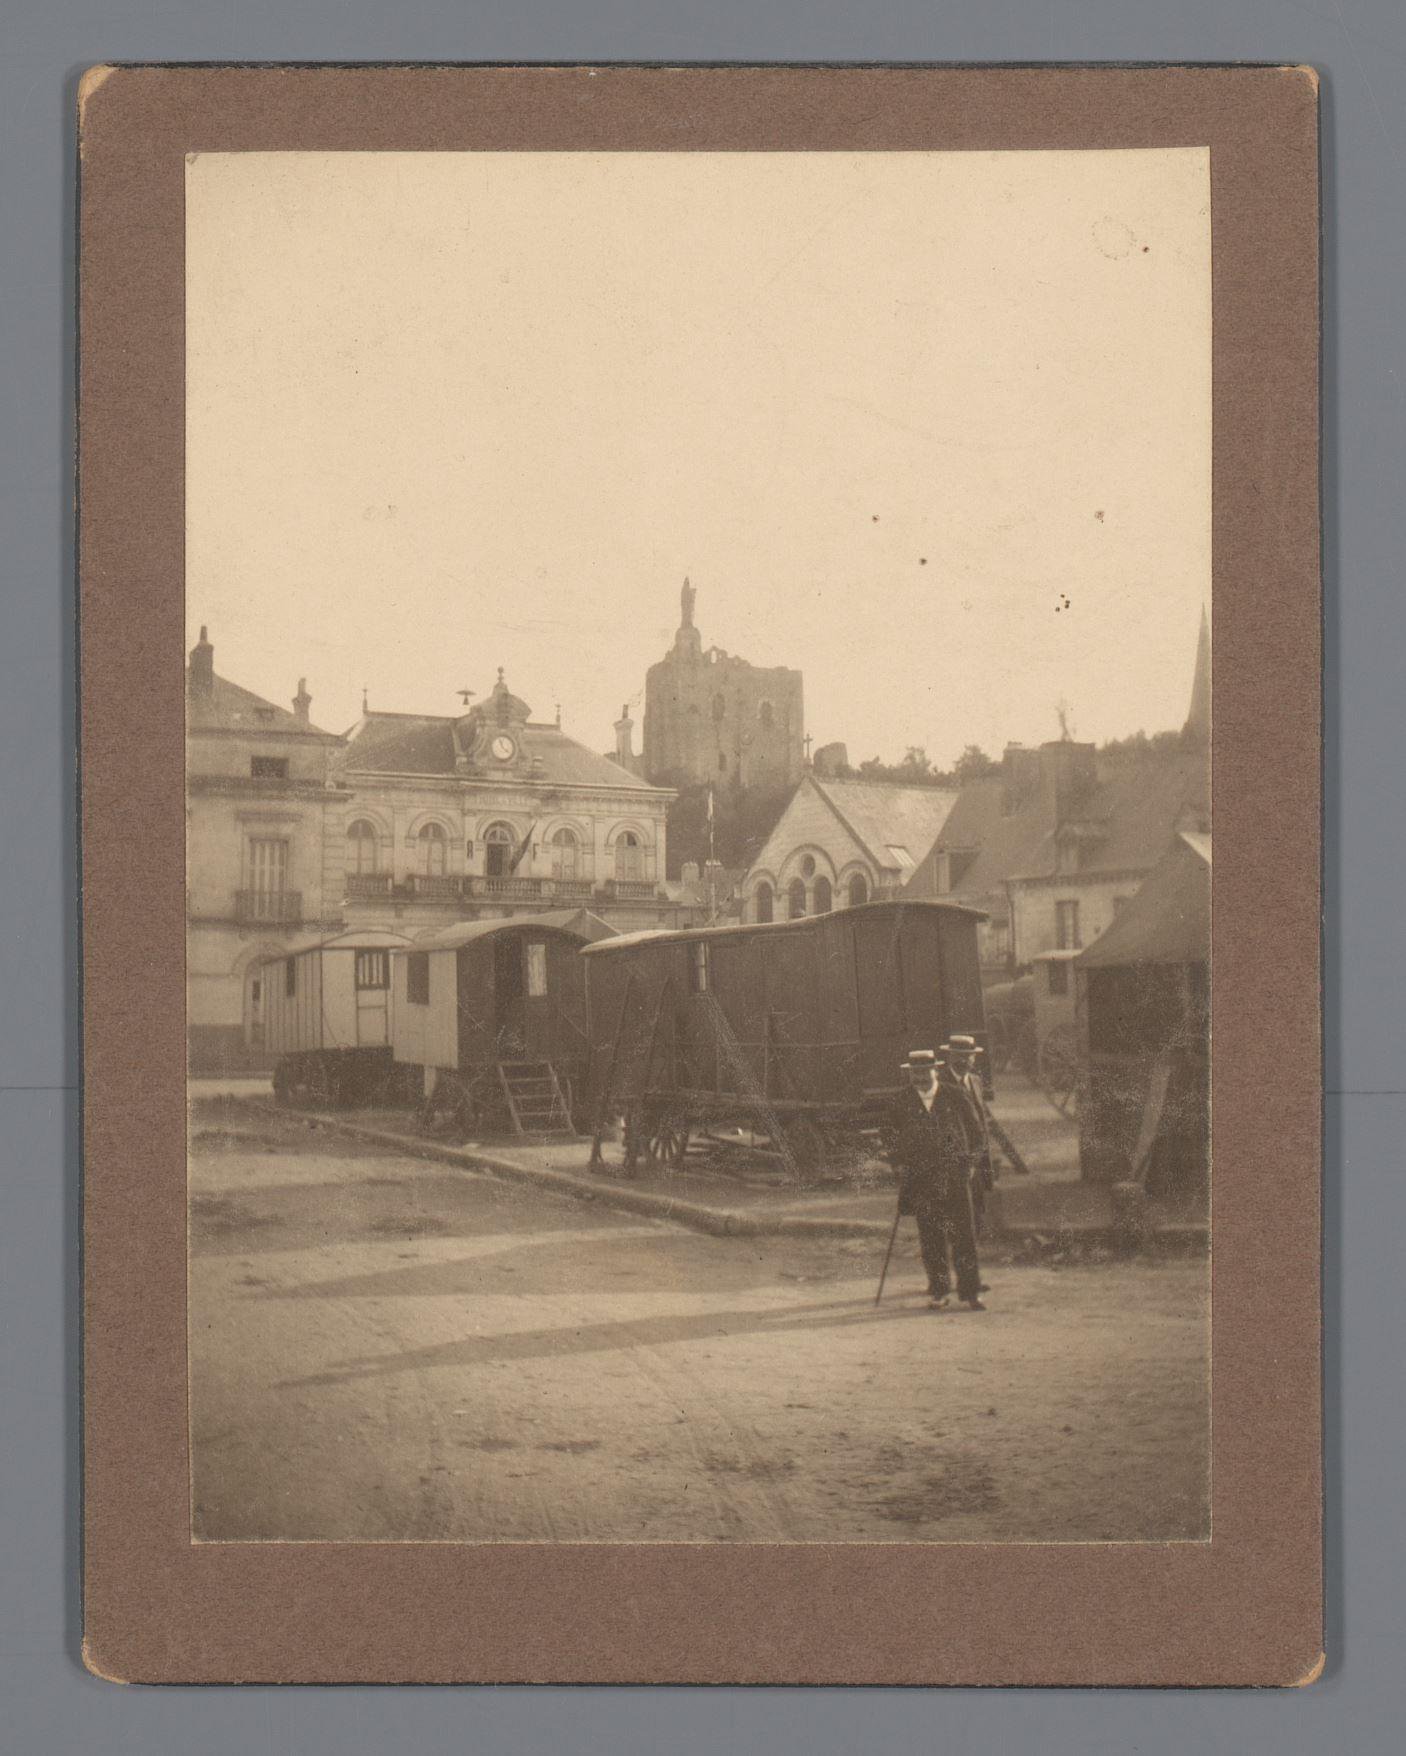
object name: photograph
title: Gezicht op Mont Razou (?), België (?)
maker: Anonymous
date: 1880-1910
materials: cardboard, paper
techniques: collodion silver print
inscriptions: annotation: ‘Mont Razou (?)’, annotation: ‘19 sept 9 1/2’, number: ‘39’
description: Gezicht op een stad met een hoger gelegen onbekende kerk op de achtergrond. Op de voorgrond een kruispunt, daarachter woonwagens, huizen en op het kruispunt twee mannen met pak, wandelstok en lichte hoeden.